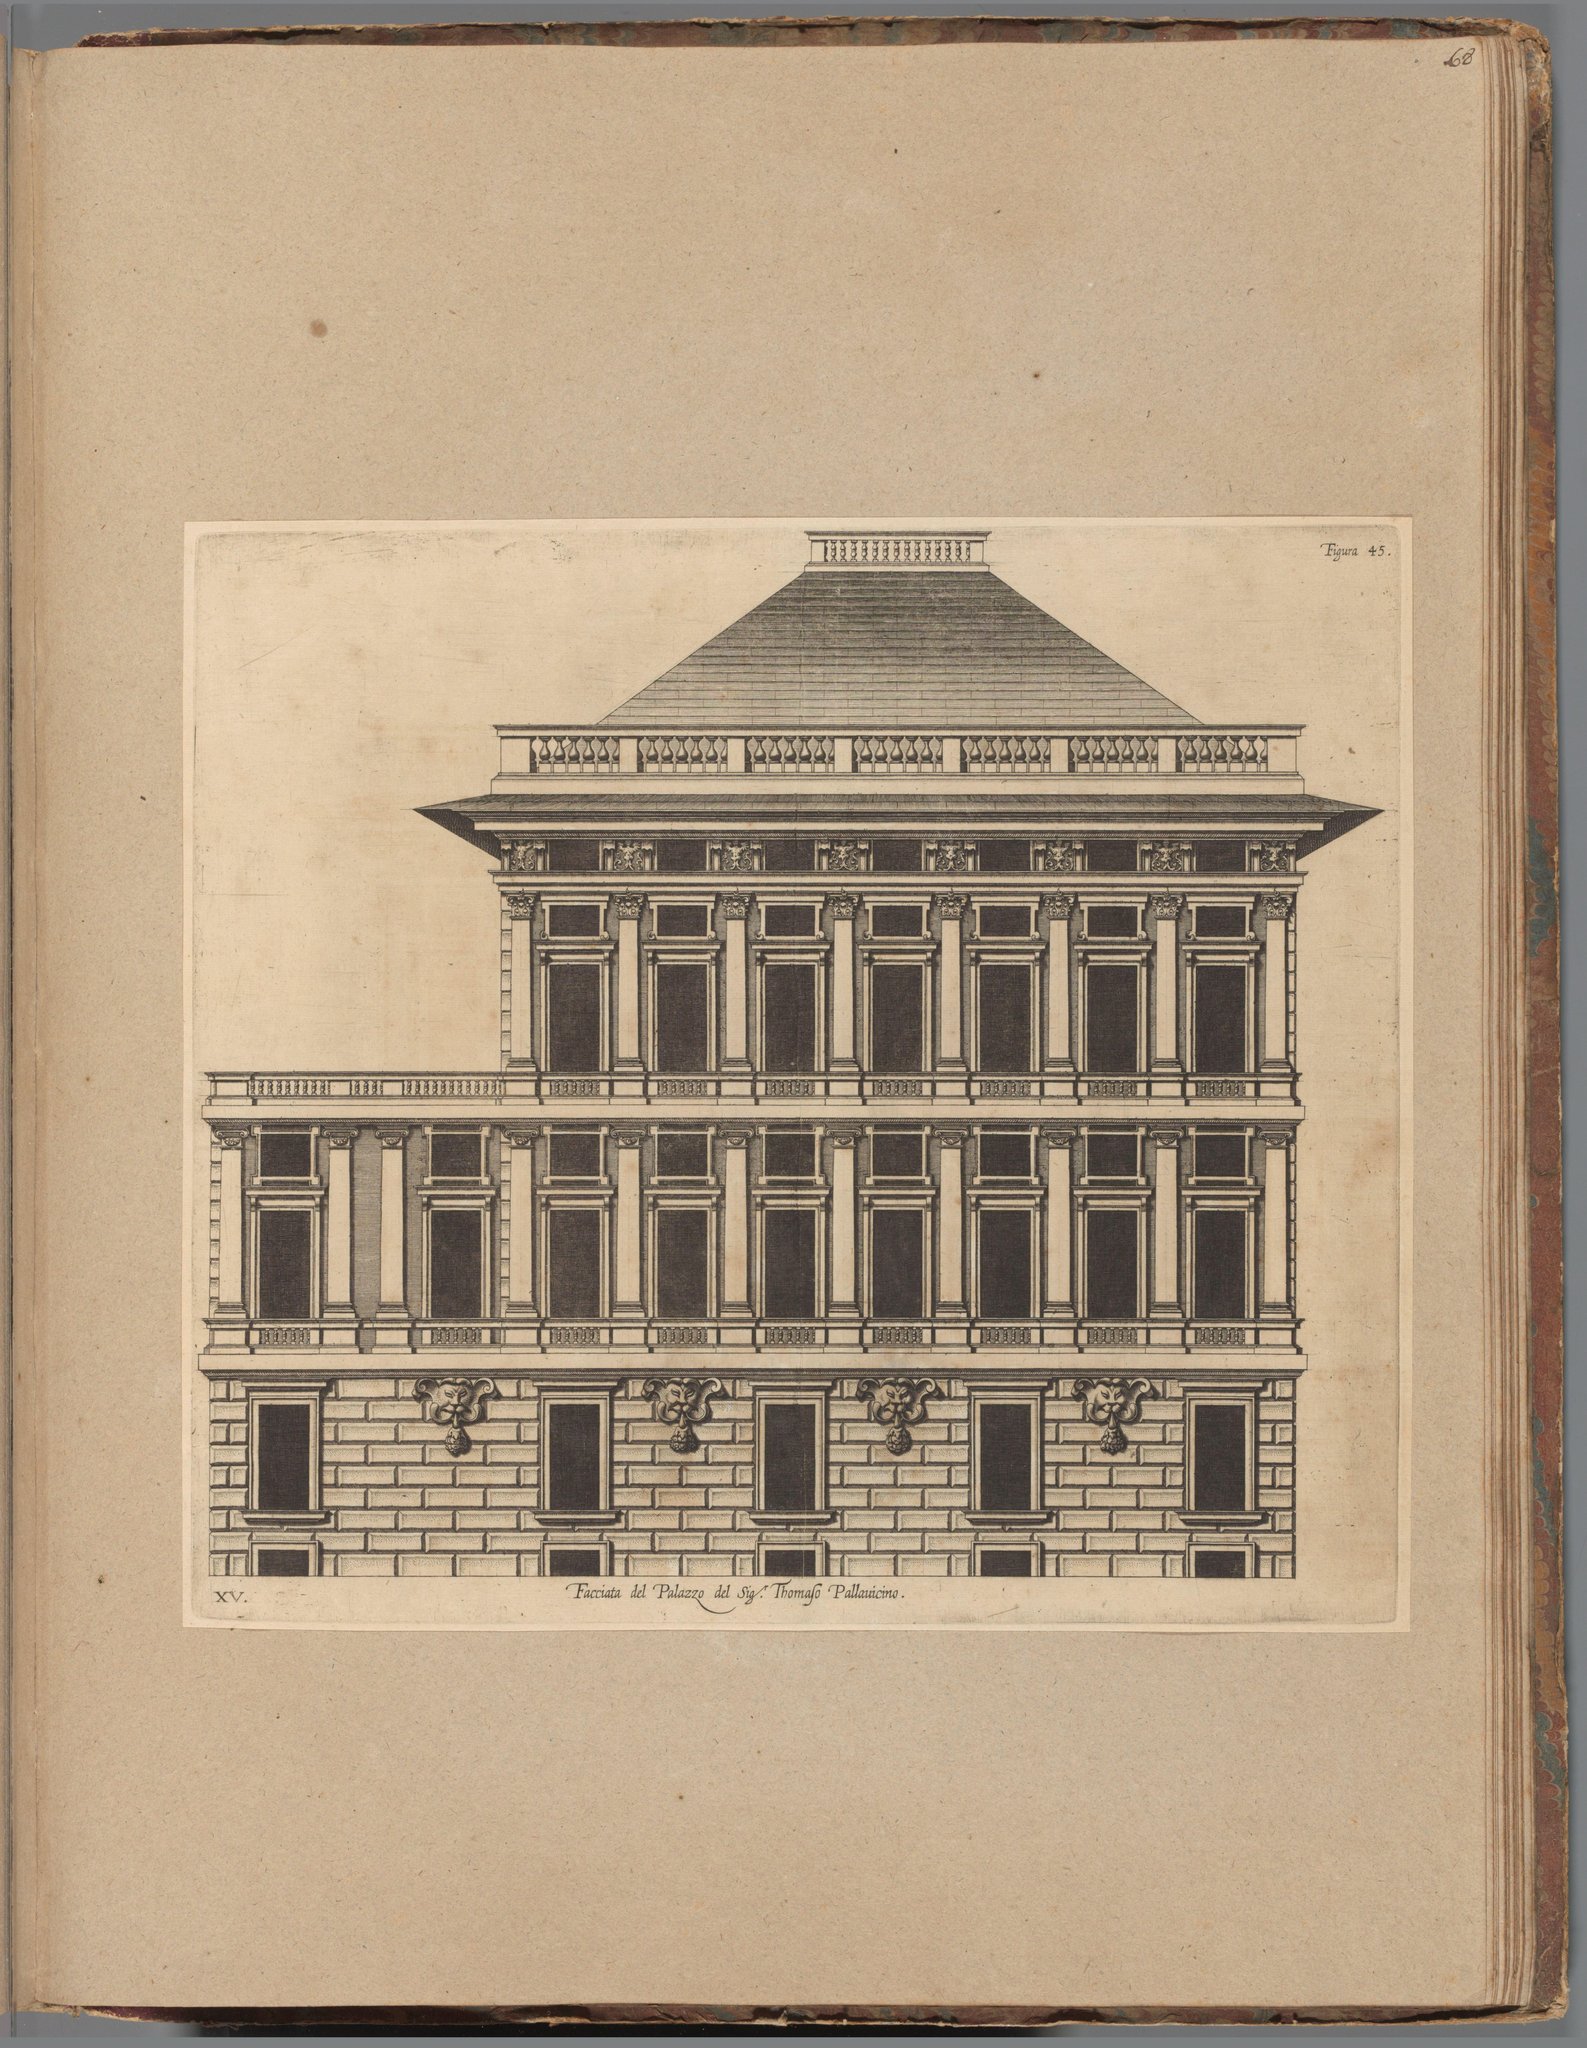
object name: album leaf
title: Facciata del Palazzo del sigr. Thomaso Pallavicino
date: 1622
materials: paper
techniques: engraving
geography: antwerp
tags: hôtel, i.e. small palace in city, façade (of house or building), exterior ~ architectural design or model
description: Deze prent maakt deel uit van een album.